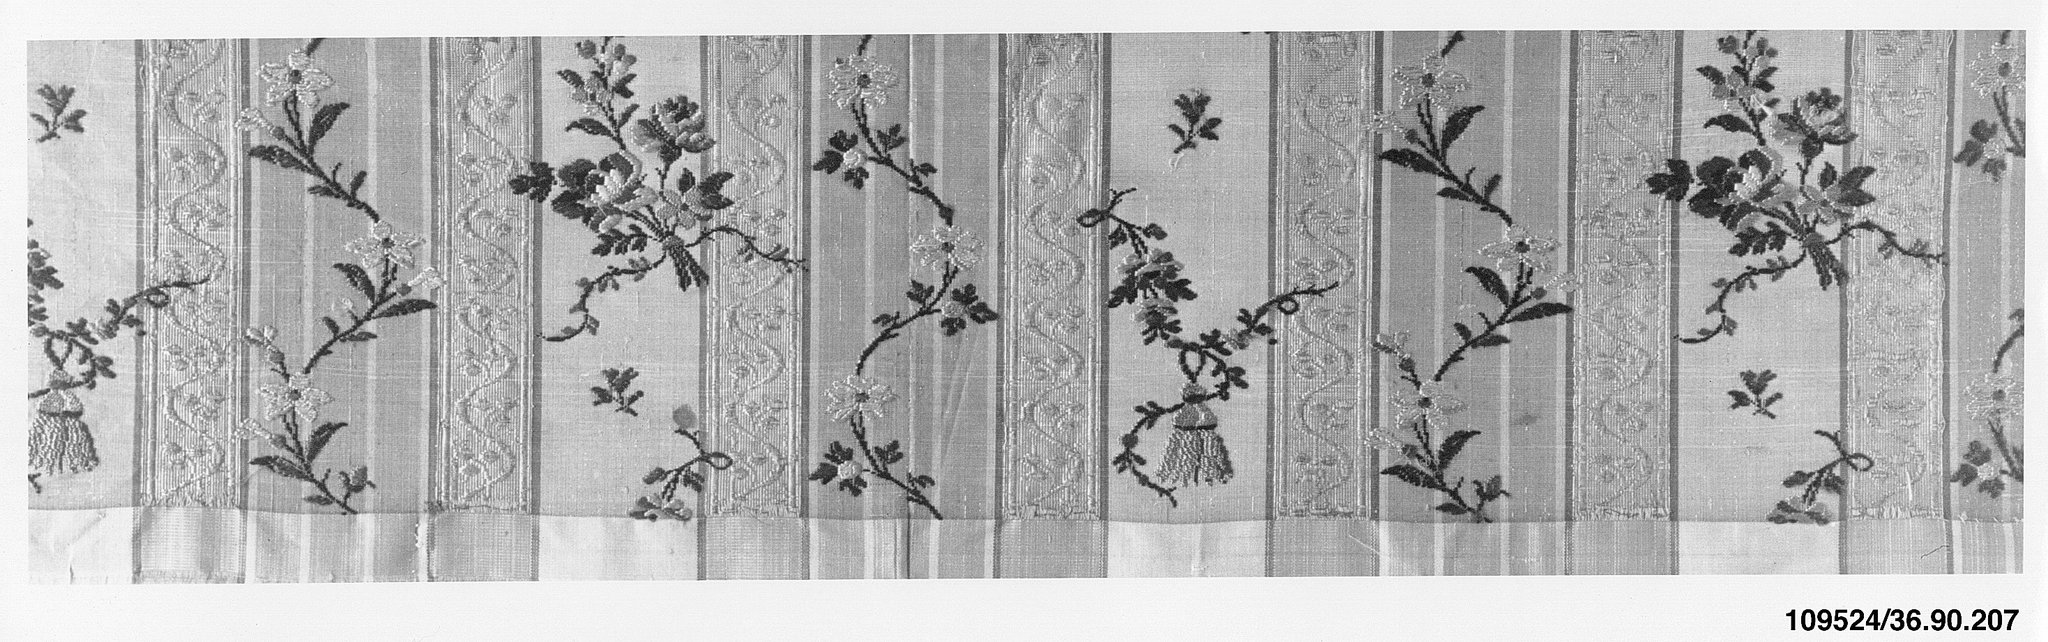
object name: piece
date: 1701-1800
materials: metal thread, silk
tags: flowers,leaves